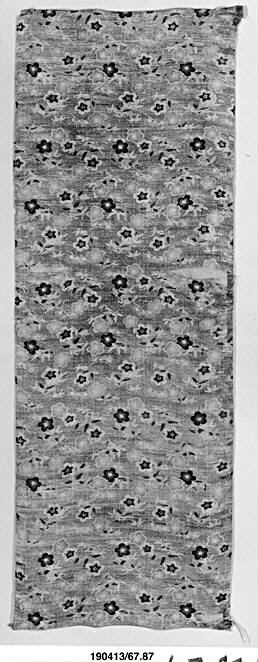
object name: length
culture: japanese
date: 1900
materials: silk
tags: flowers